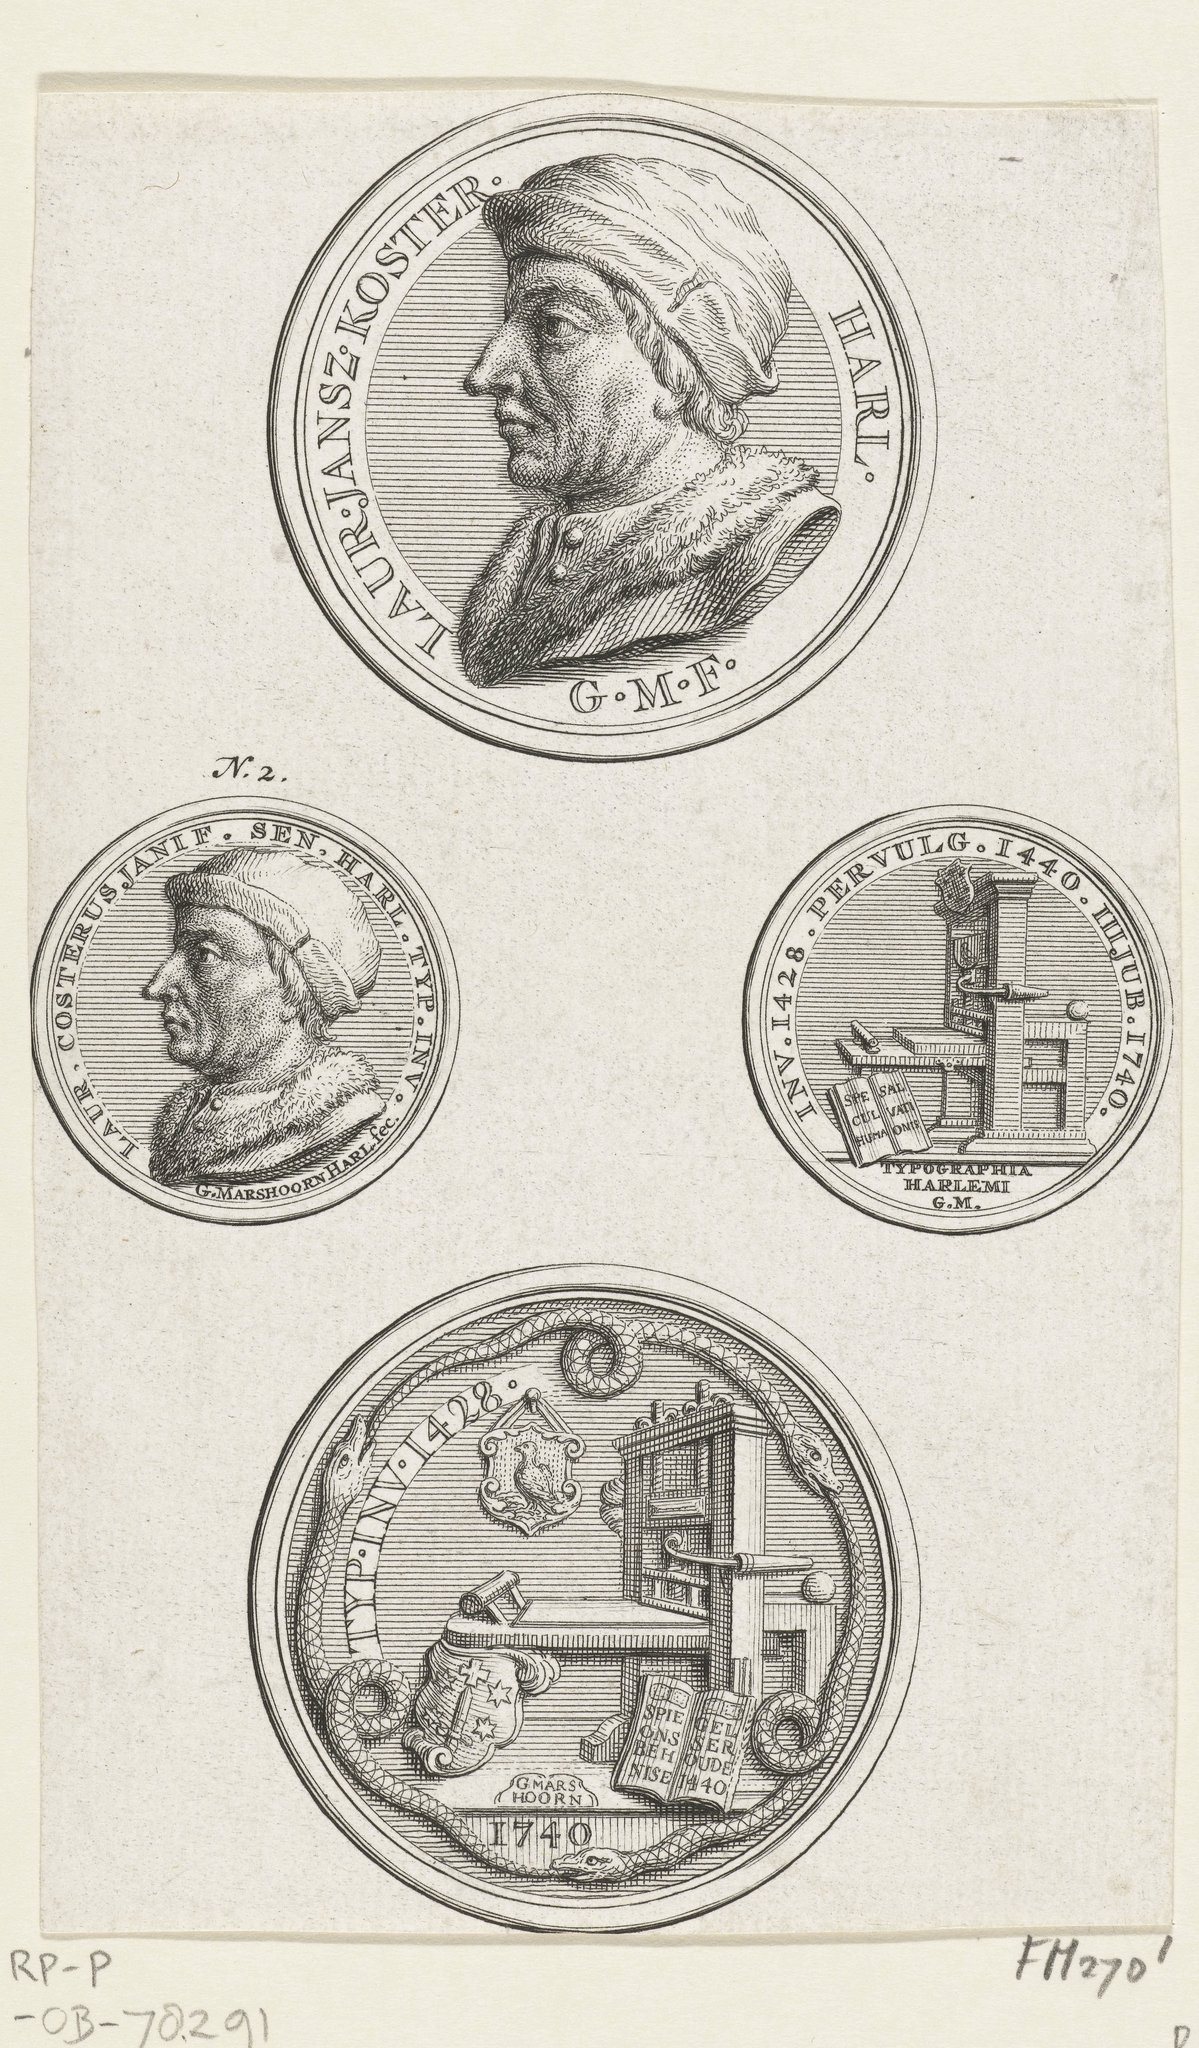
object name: historical object representation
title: Penningen ter gelegenheid van het derde eeuwfeest van de uitvinding van de boekdrukkunst in 1740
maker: Anonymous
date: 1738-1740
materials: paper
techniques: etching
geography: northern netherlands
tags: haarlem, printing press, medal (considered as a piece of sculpture, regardless of its specific function), printer, burgundian netherlands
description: Twee penningen, voor- en achterzijde, geslagen in 1740 ter gelegenheid van het derde eeuwfeest van de uitvinding van de boekdrukkunst. Afbeeldingen van Laurens Jansz. Coster en een drukpers.